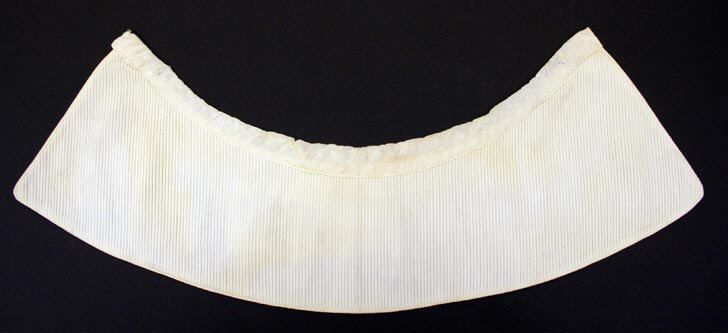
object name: collar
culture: american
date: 1700-1943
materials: cotton